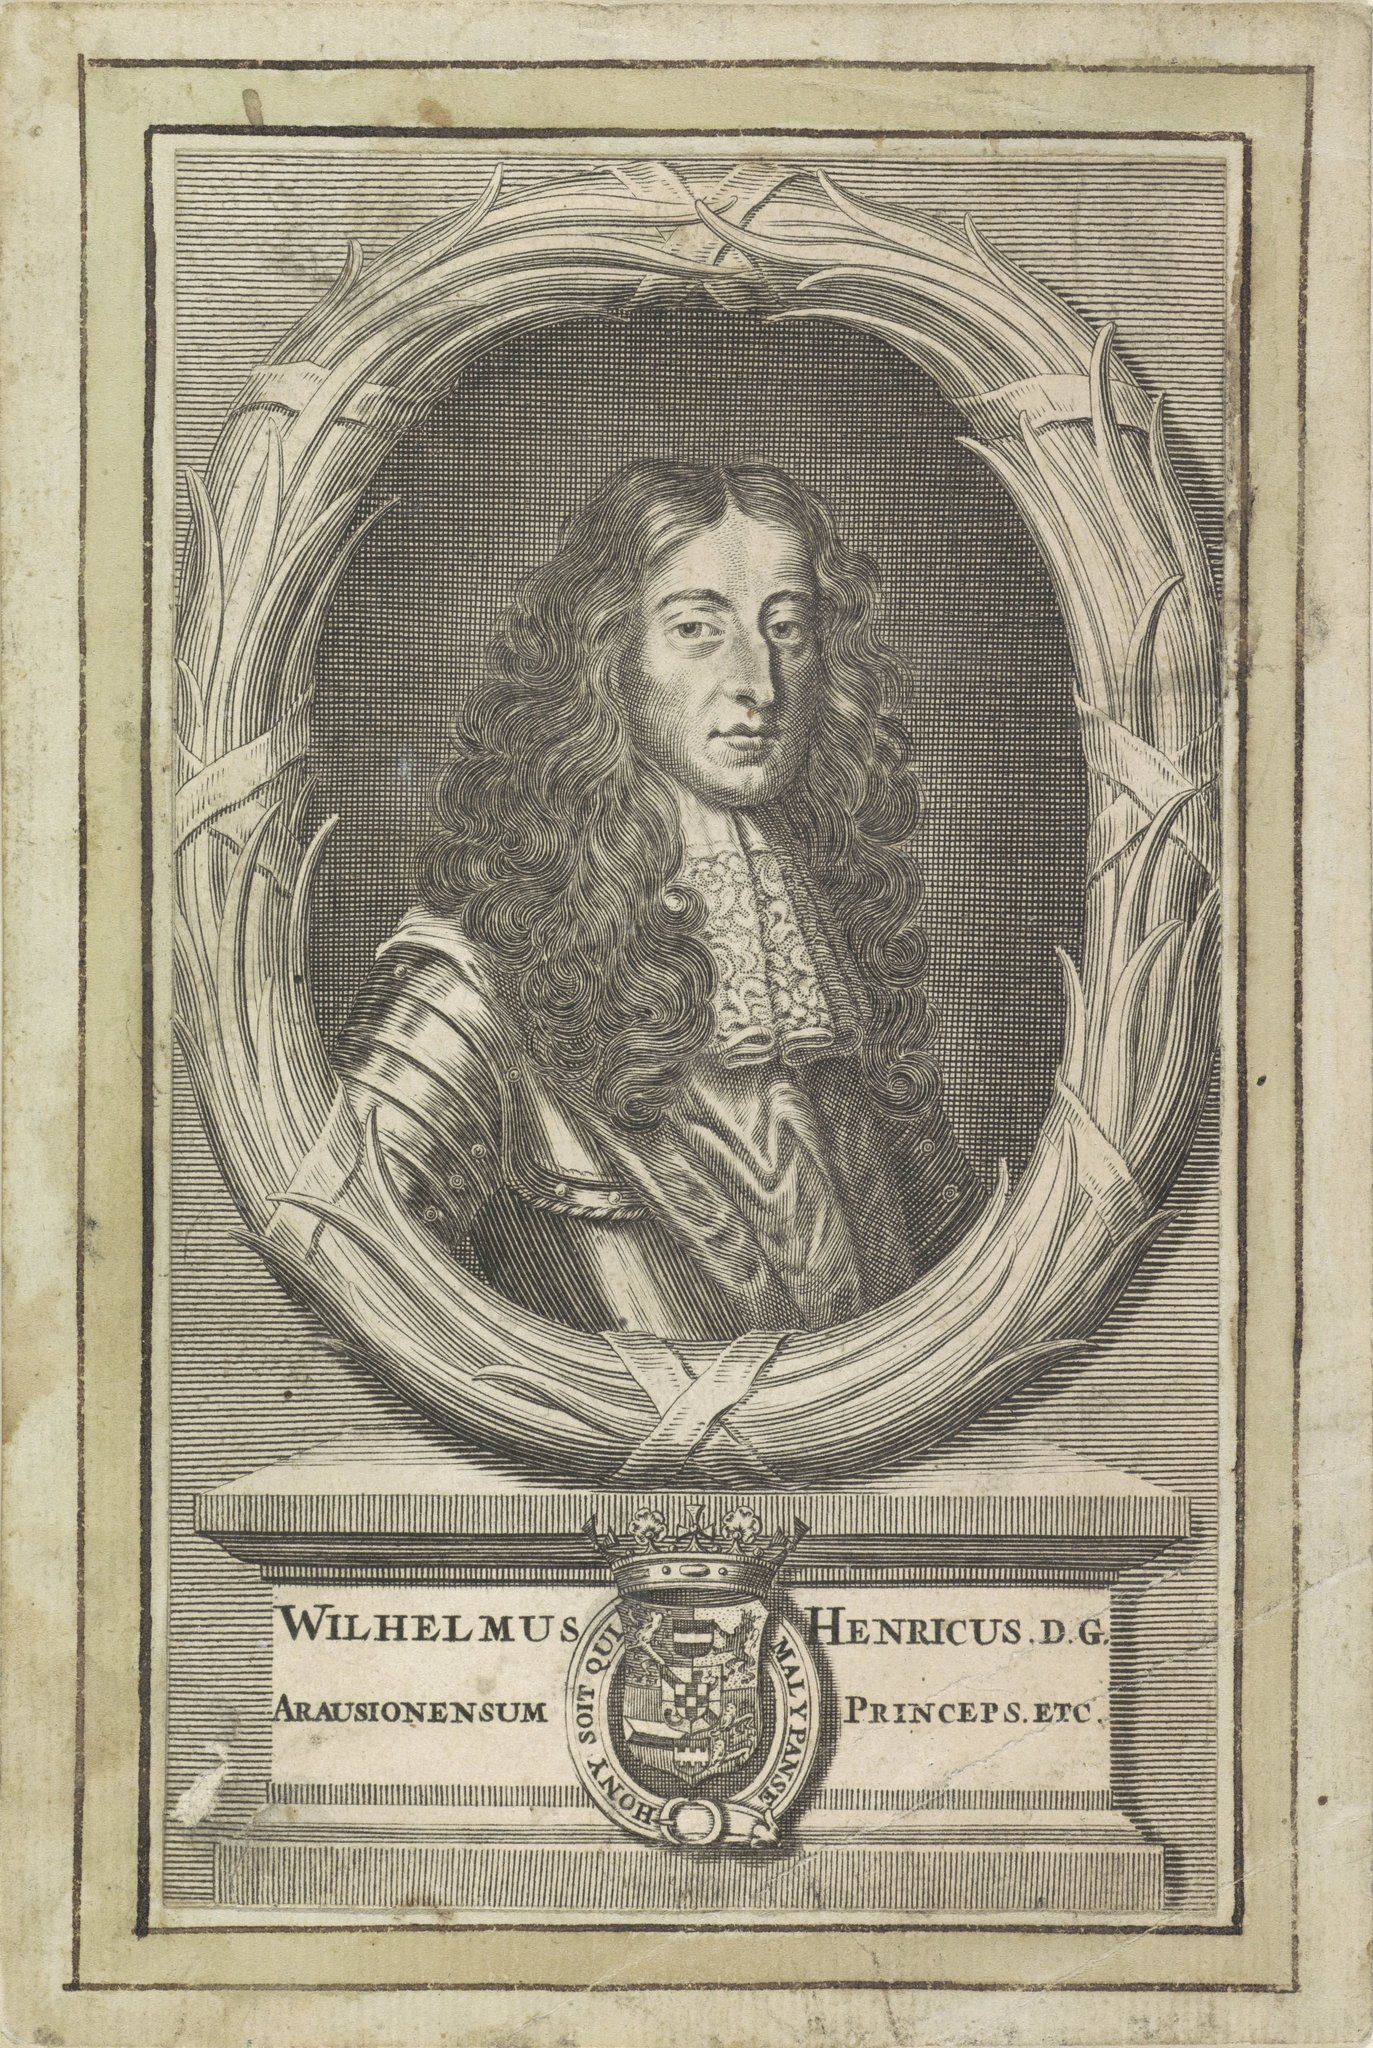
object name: print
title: Portret van Willem III, prins van Oranje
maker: Anonymous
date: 1670-1749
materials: paper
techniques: engraving, etching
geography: low countries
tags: william iii (prince of orange and king of england, scotland, and ireland), knighthood order (garter) - insignia of a knighthood order, e.g.: badge, chain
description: Portret van Willem III in een ovaal van lauwerbladen. Midden onder zijn wapen met een kroon, gedecoreerd met de Kousenband en het devies van de Orde van de Kousenband. Op een voetstuk zijn naam en titels.